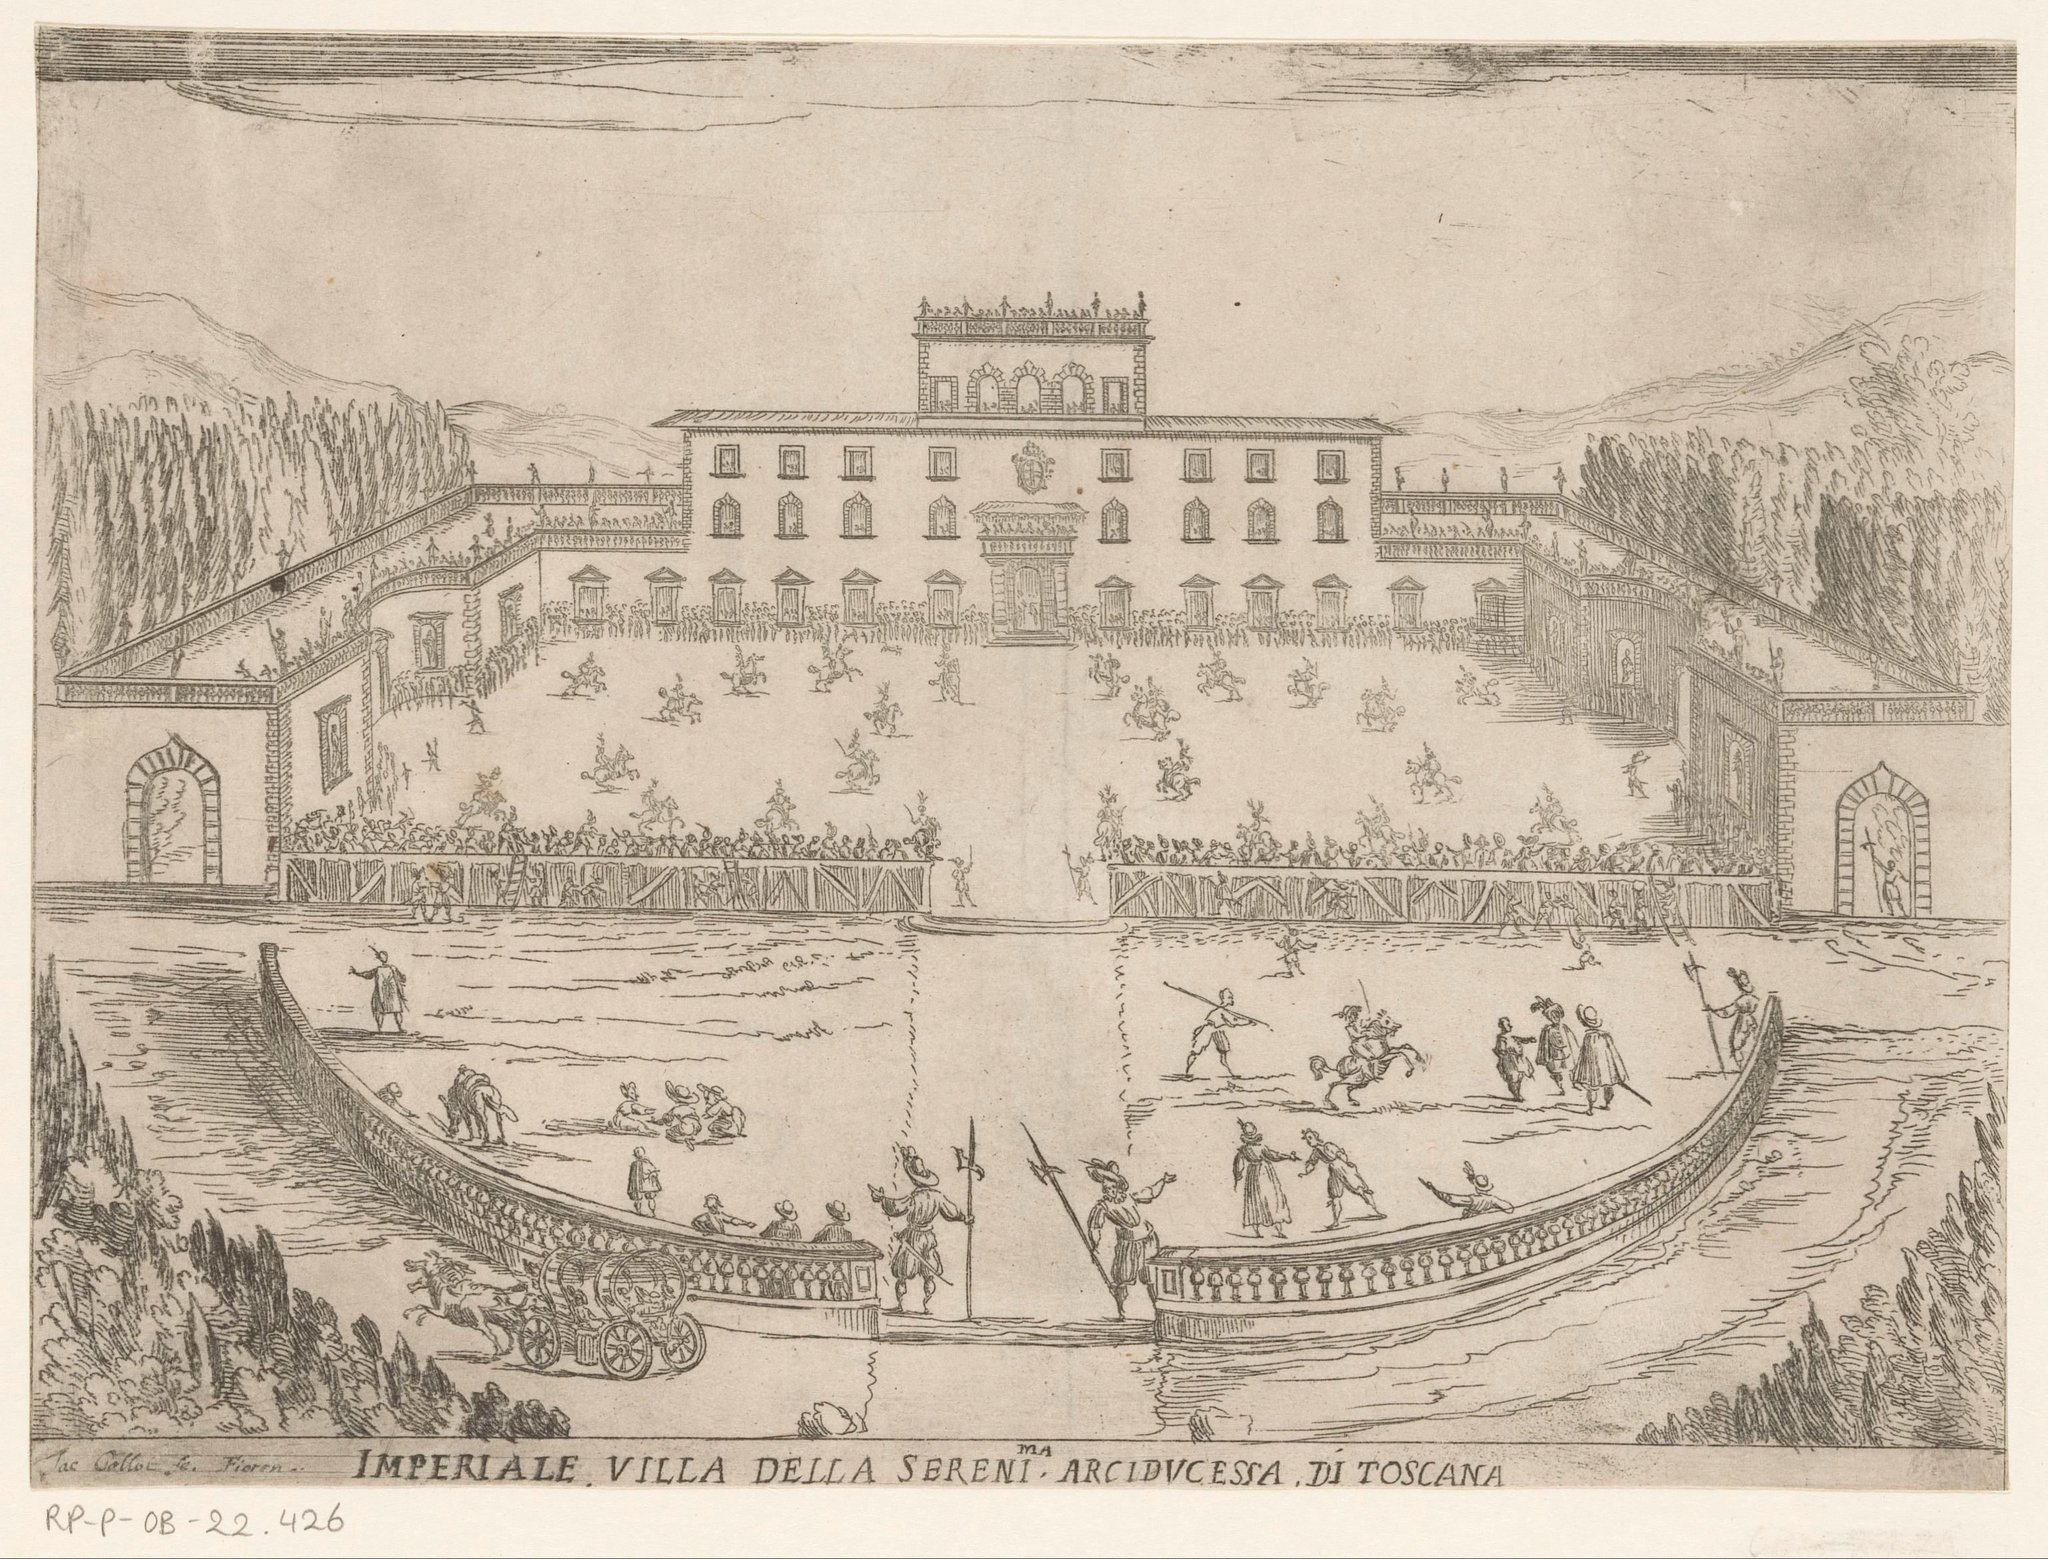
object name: print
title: Imperiale villa della Sereni.ma Arciducessa di Toscana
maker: alfonso parigi (il giovane)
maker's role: print maker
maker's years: 1606-1656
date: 1616-1656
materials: paper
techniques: etching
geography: italy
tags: public festivities, villa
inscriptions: collector's mark: Lugt 240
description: Gezicht op de villa van de aartshertogin van Toscane. Voor de villa vinden spelen plaats met mannen te paard. Titel in het Italiaans in ondermarge.